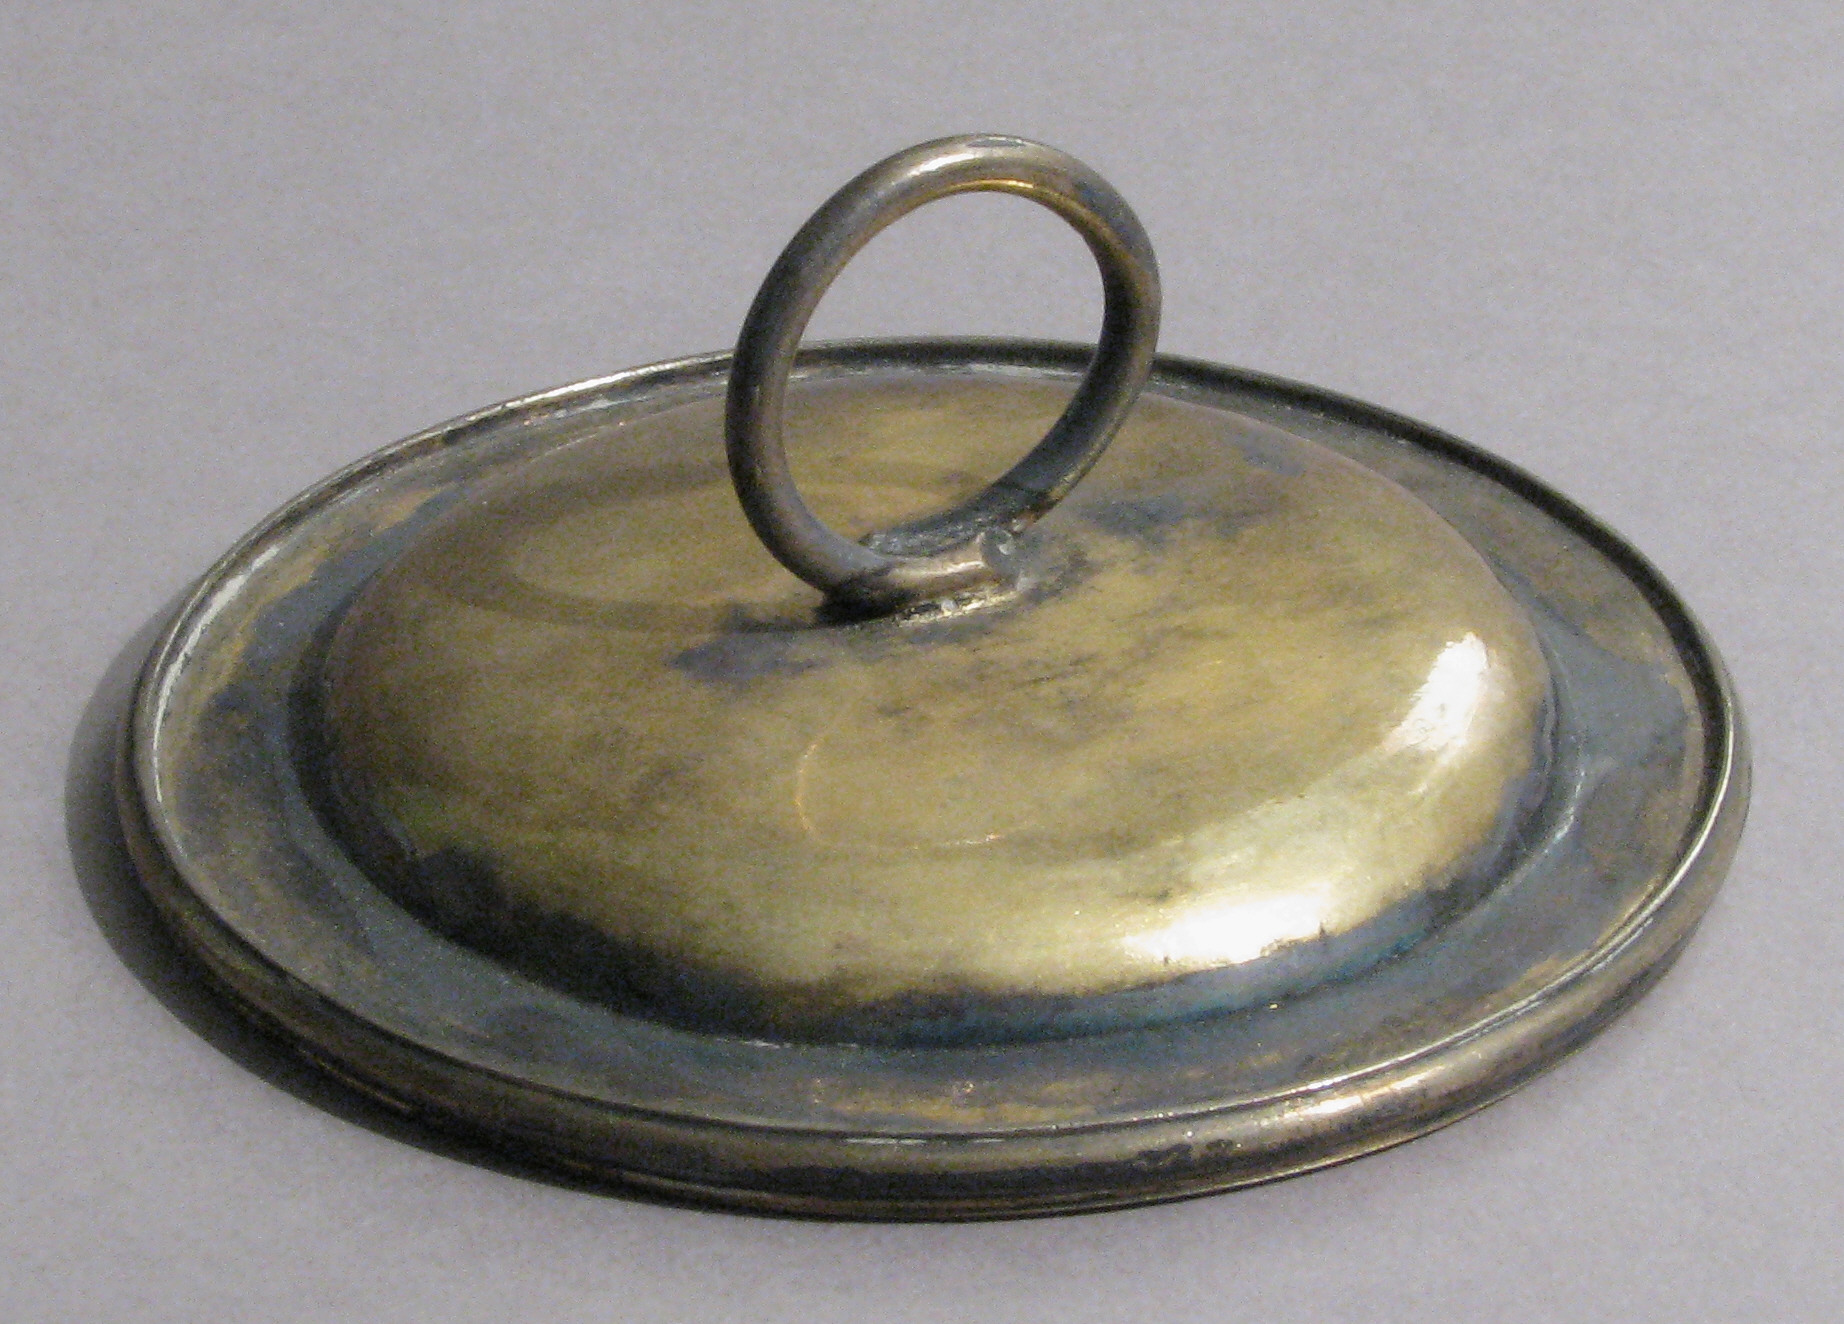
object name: cup with cover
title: Cup Cover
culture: german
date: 1401-1500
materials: silver gilt